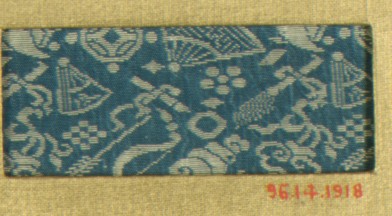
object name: piece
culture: japanese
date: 1701-1900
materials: silk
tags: fans